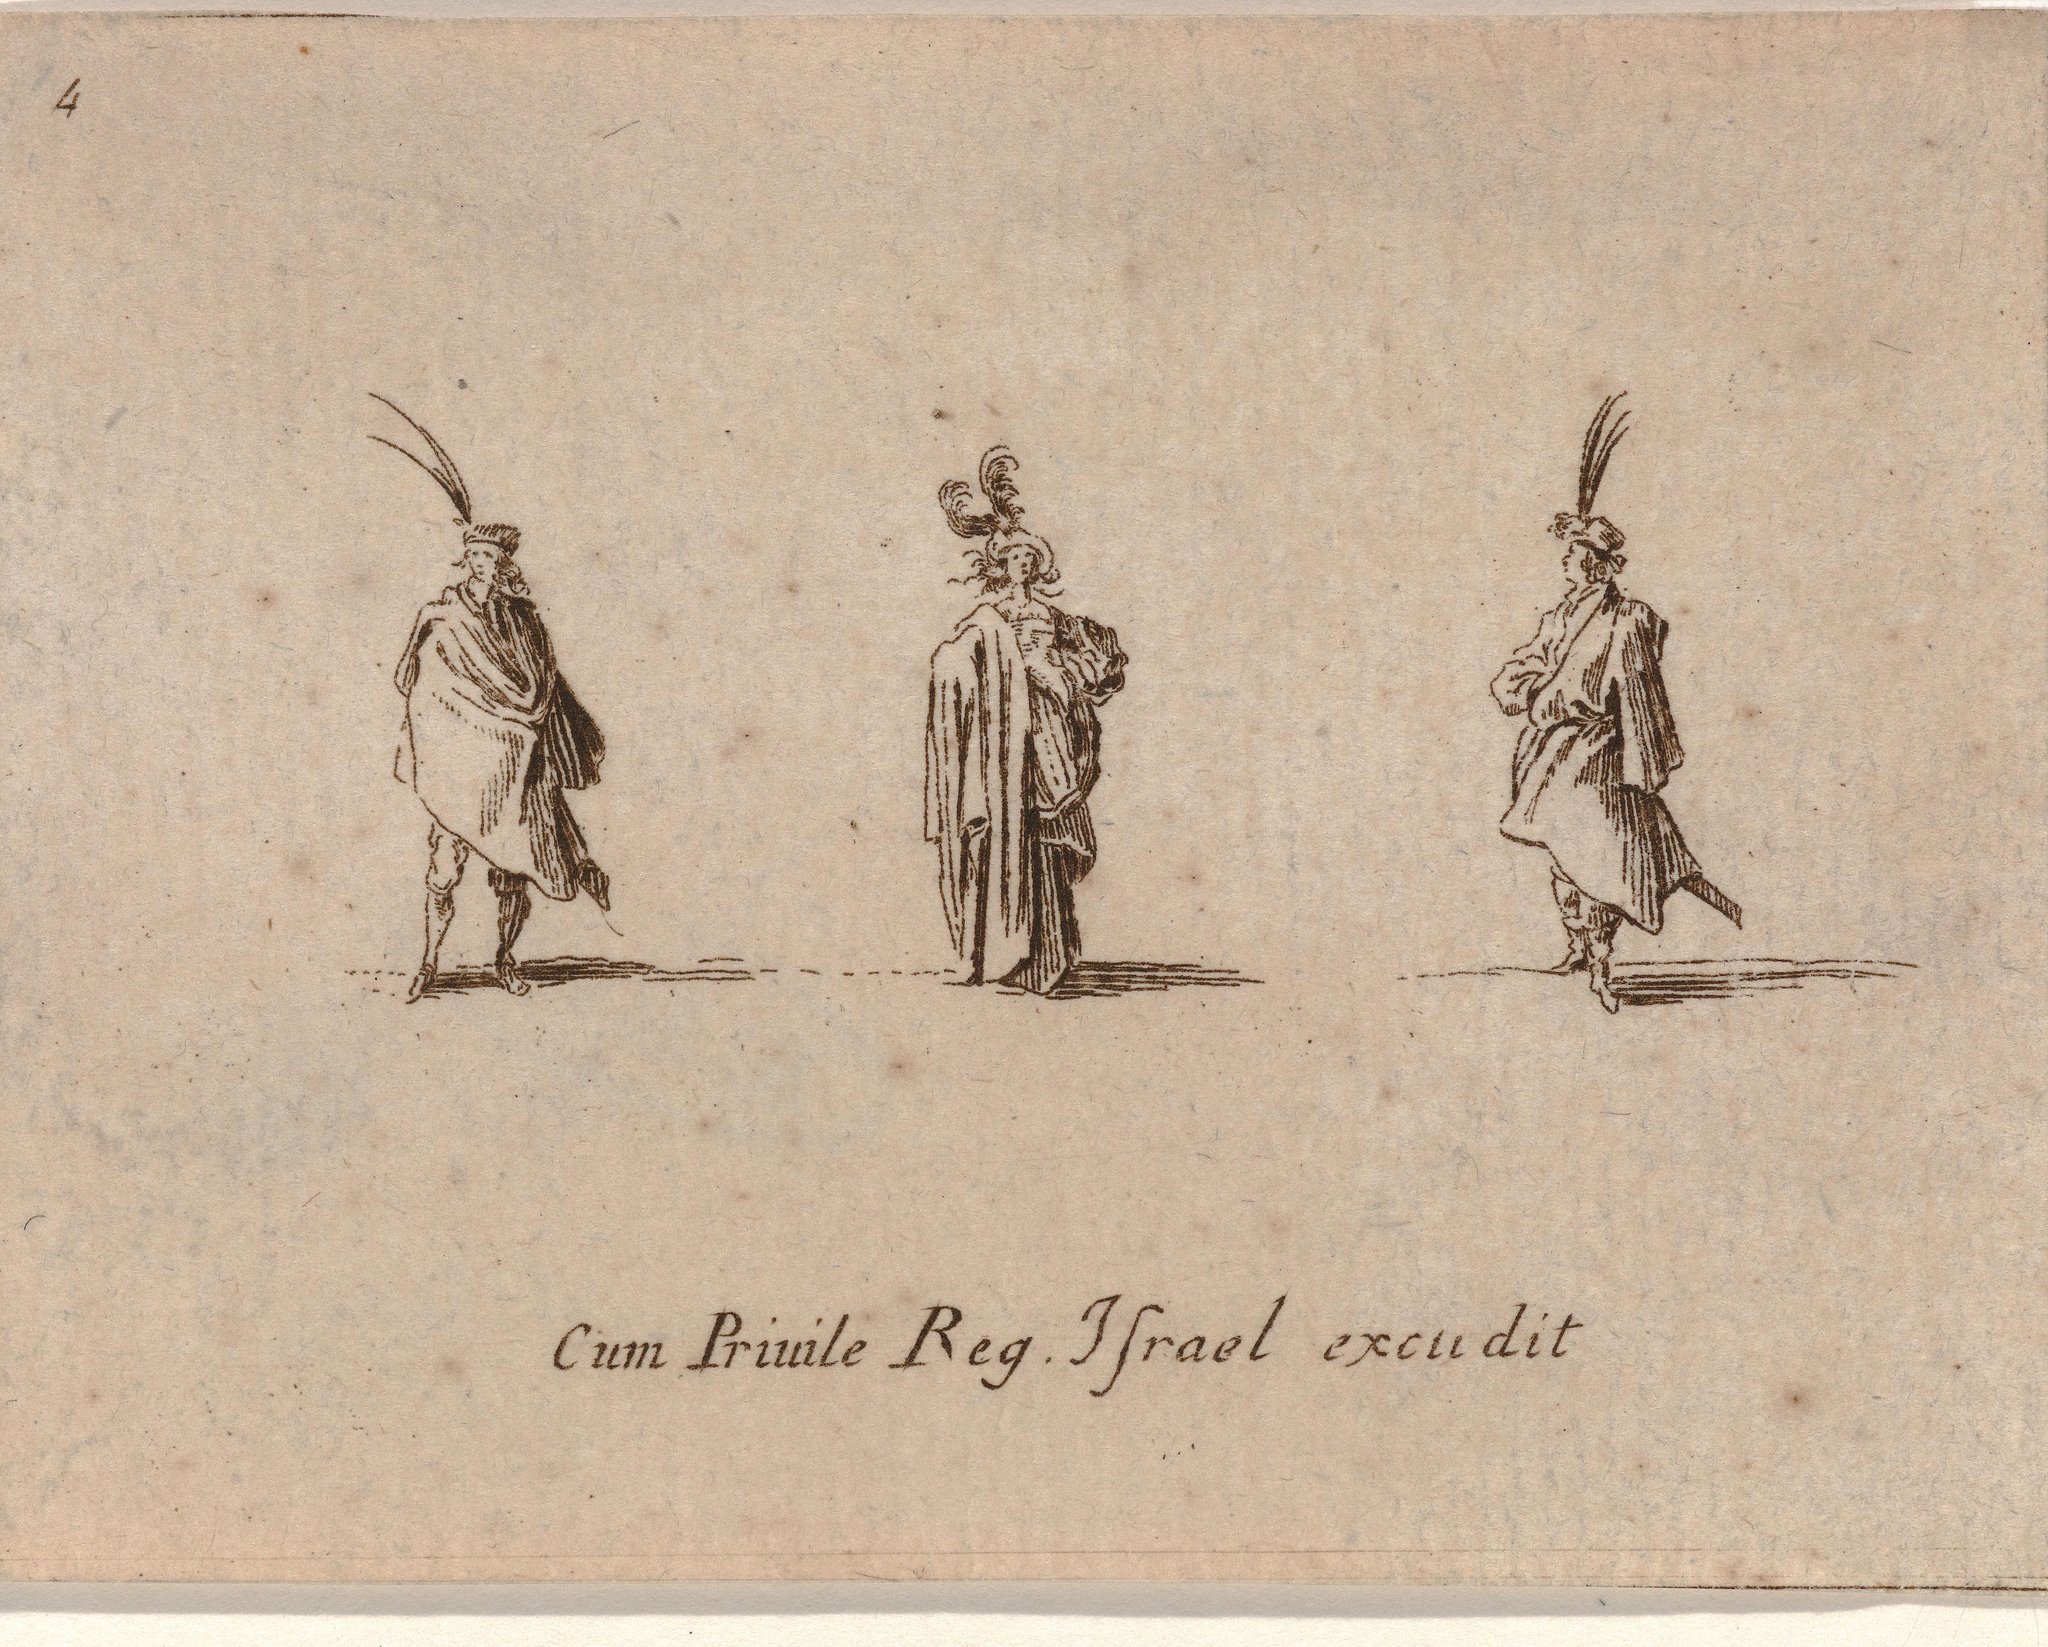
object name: print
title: Drie figuurtjes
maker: israël henriet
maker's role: printer, publisher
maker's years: 1590-1661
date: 1635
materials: paper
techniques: etching